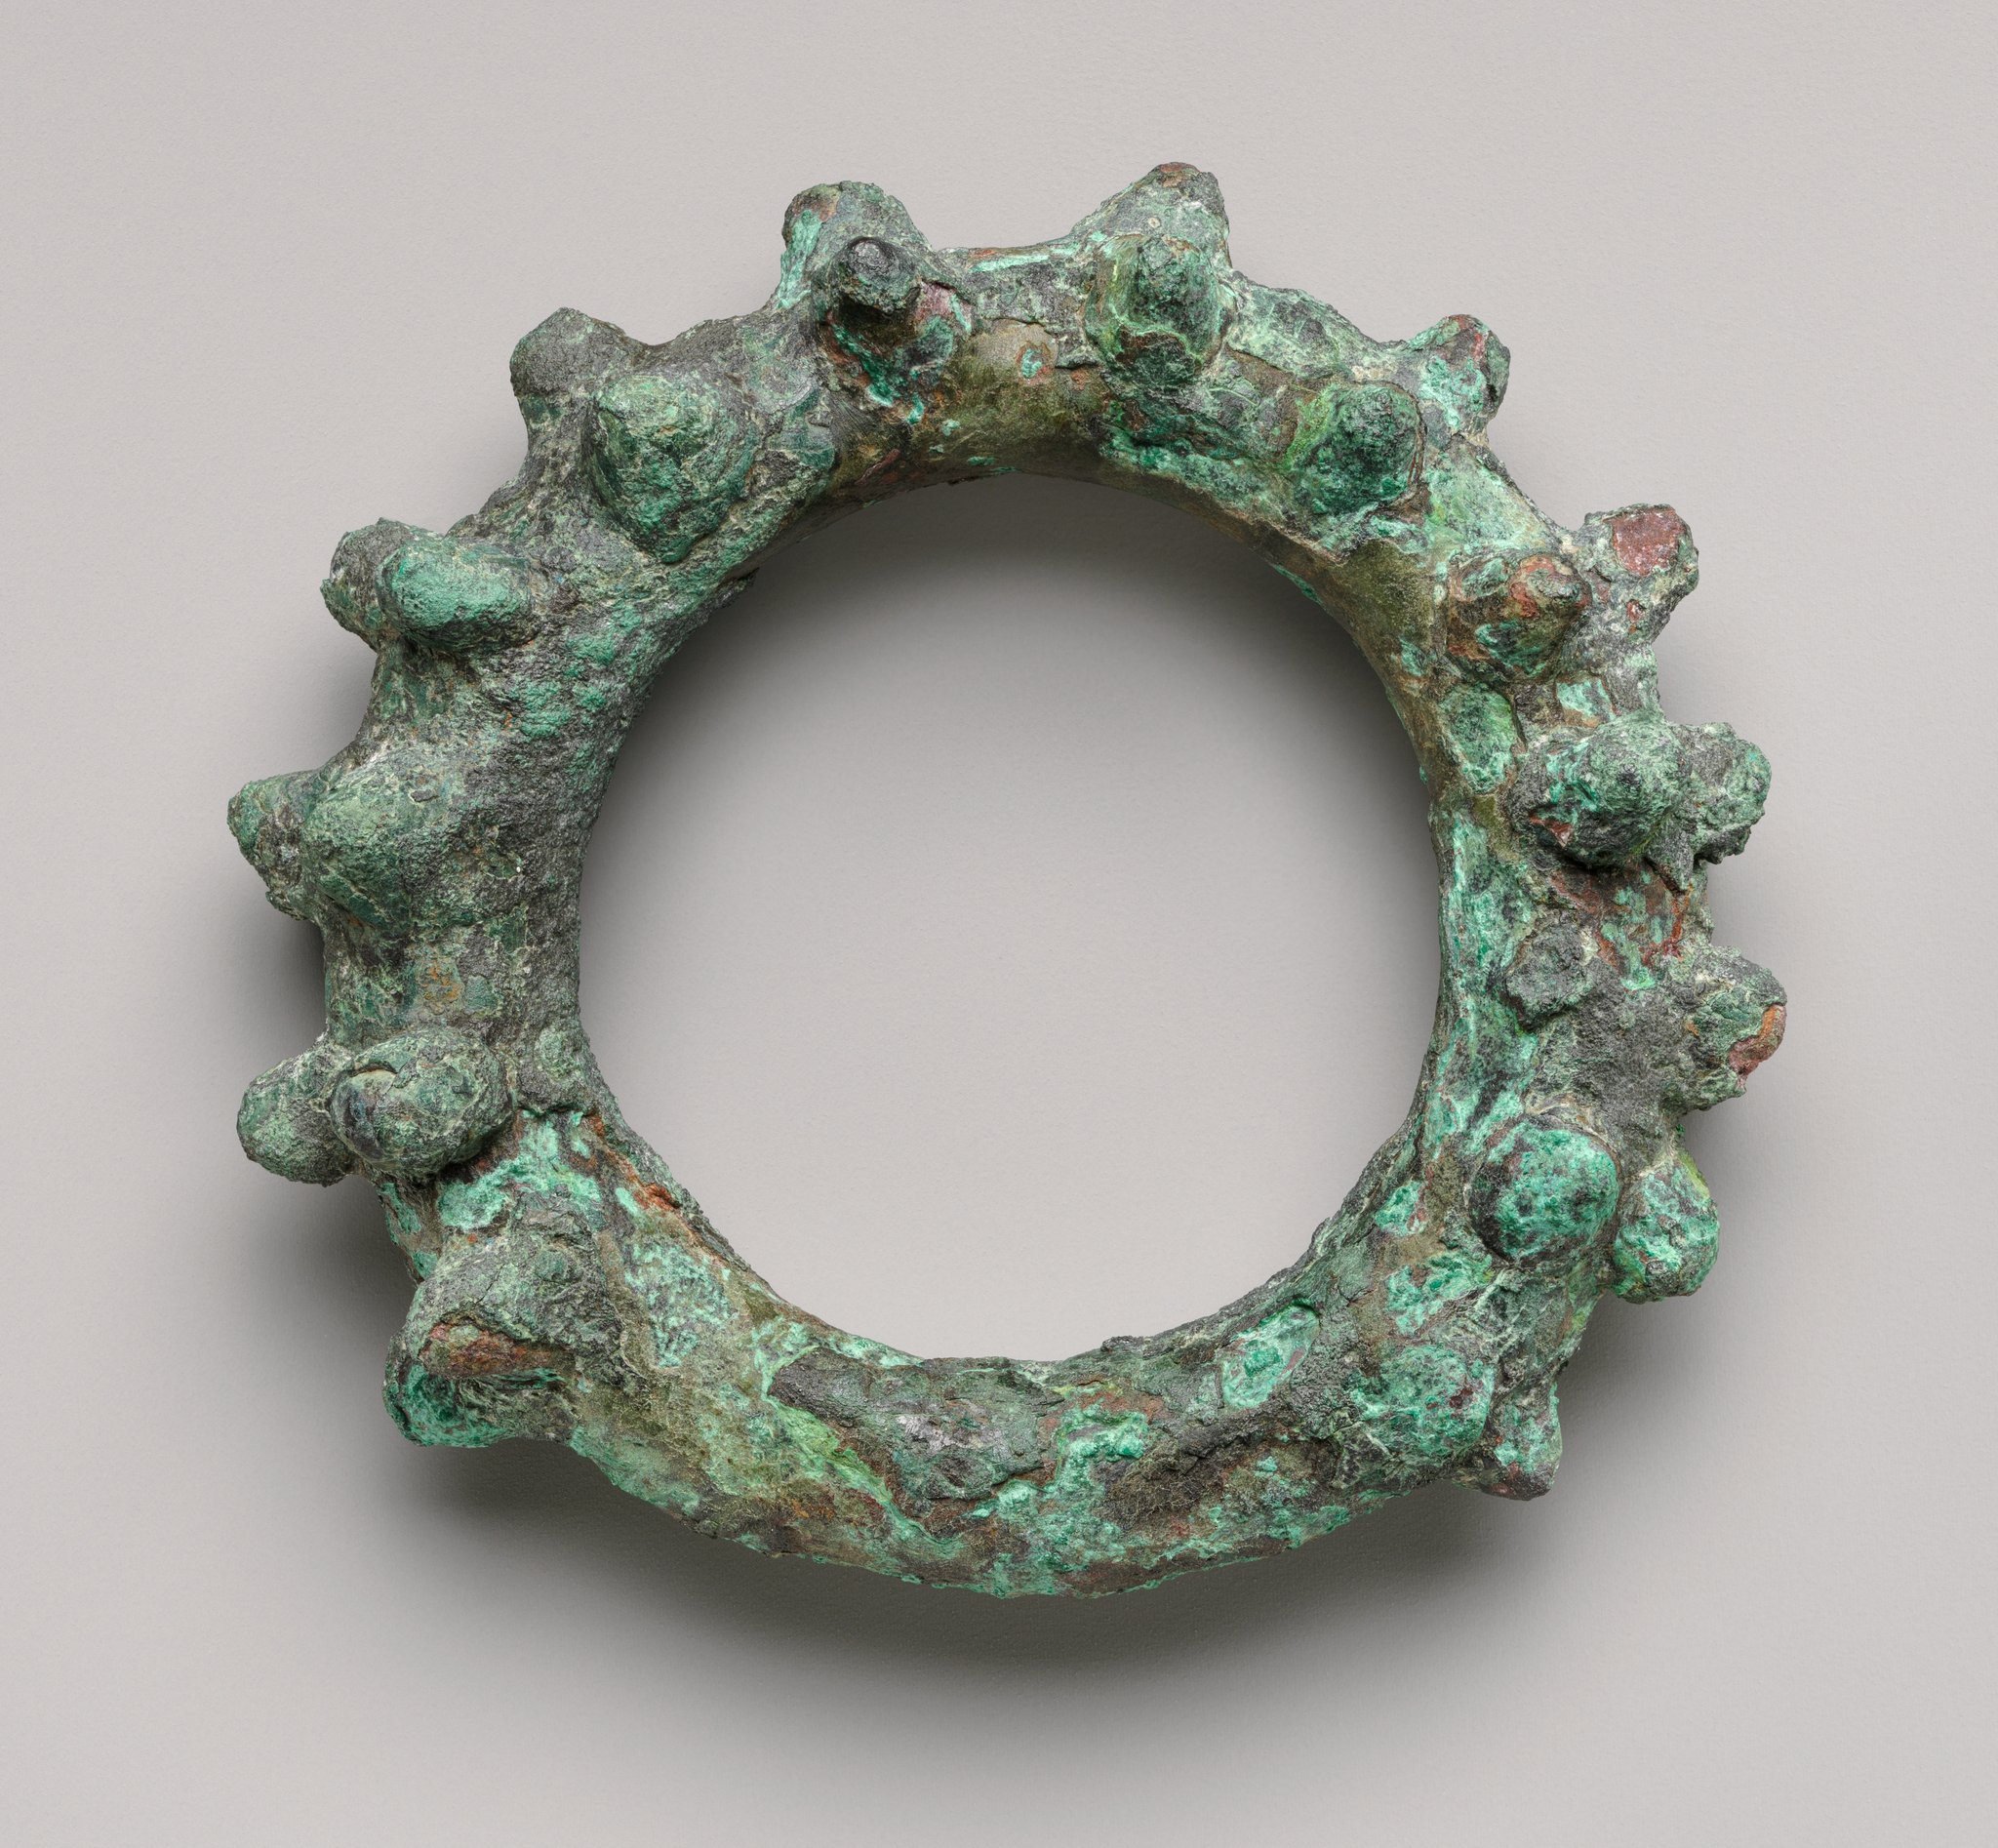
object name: ring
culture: iranian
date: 900-801 BCE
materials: bronze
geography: iran